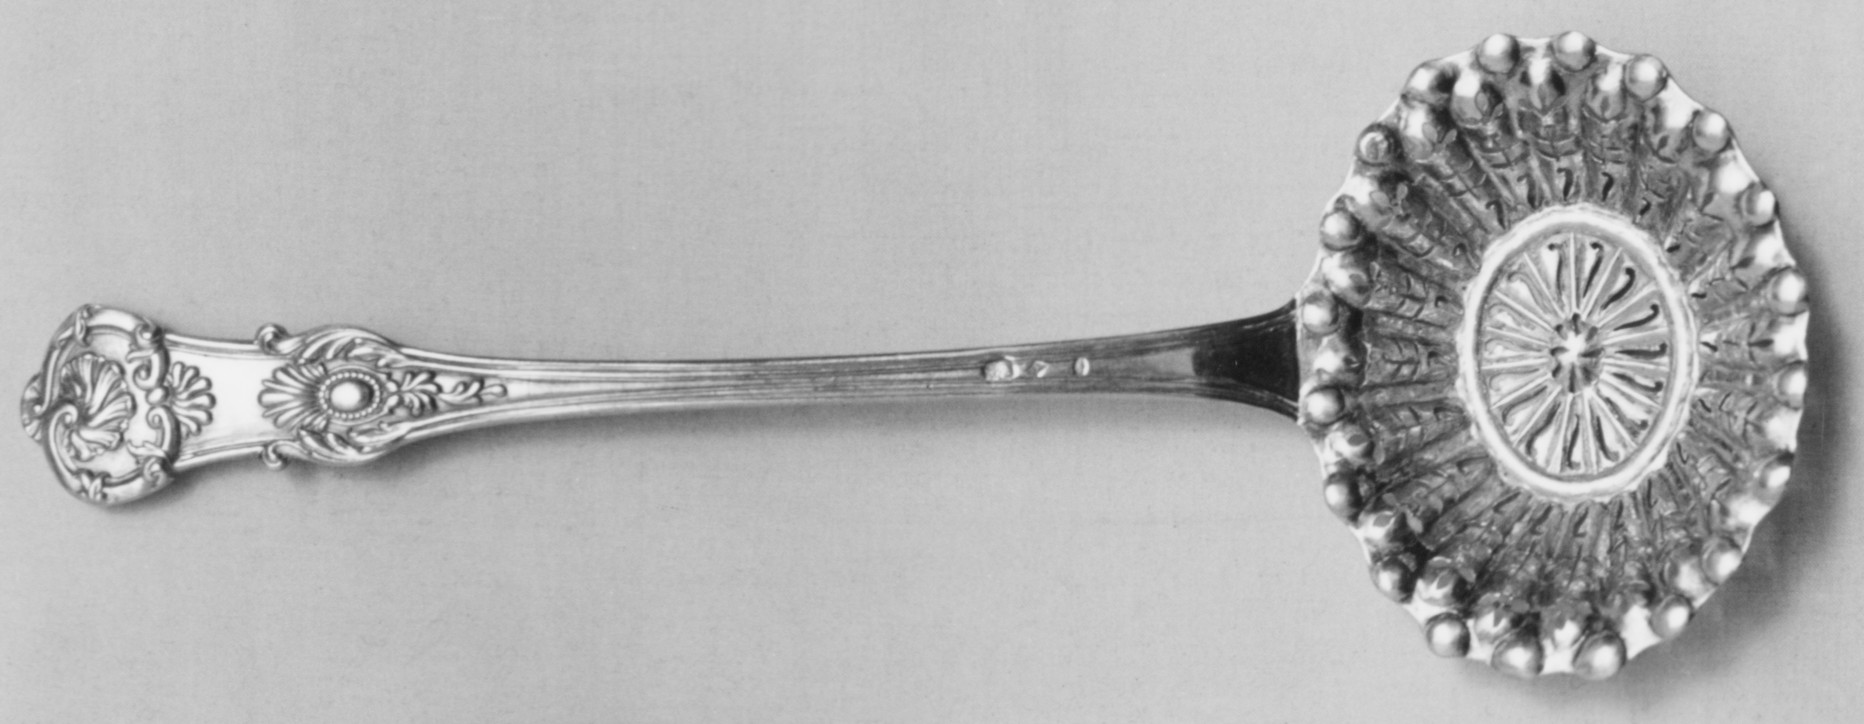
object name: sugar sifter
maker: c (?) c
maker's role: maker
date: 1819-1838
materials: silver gilt